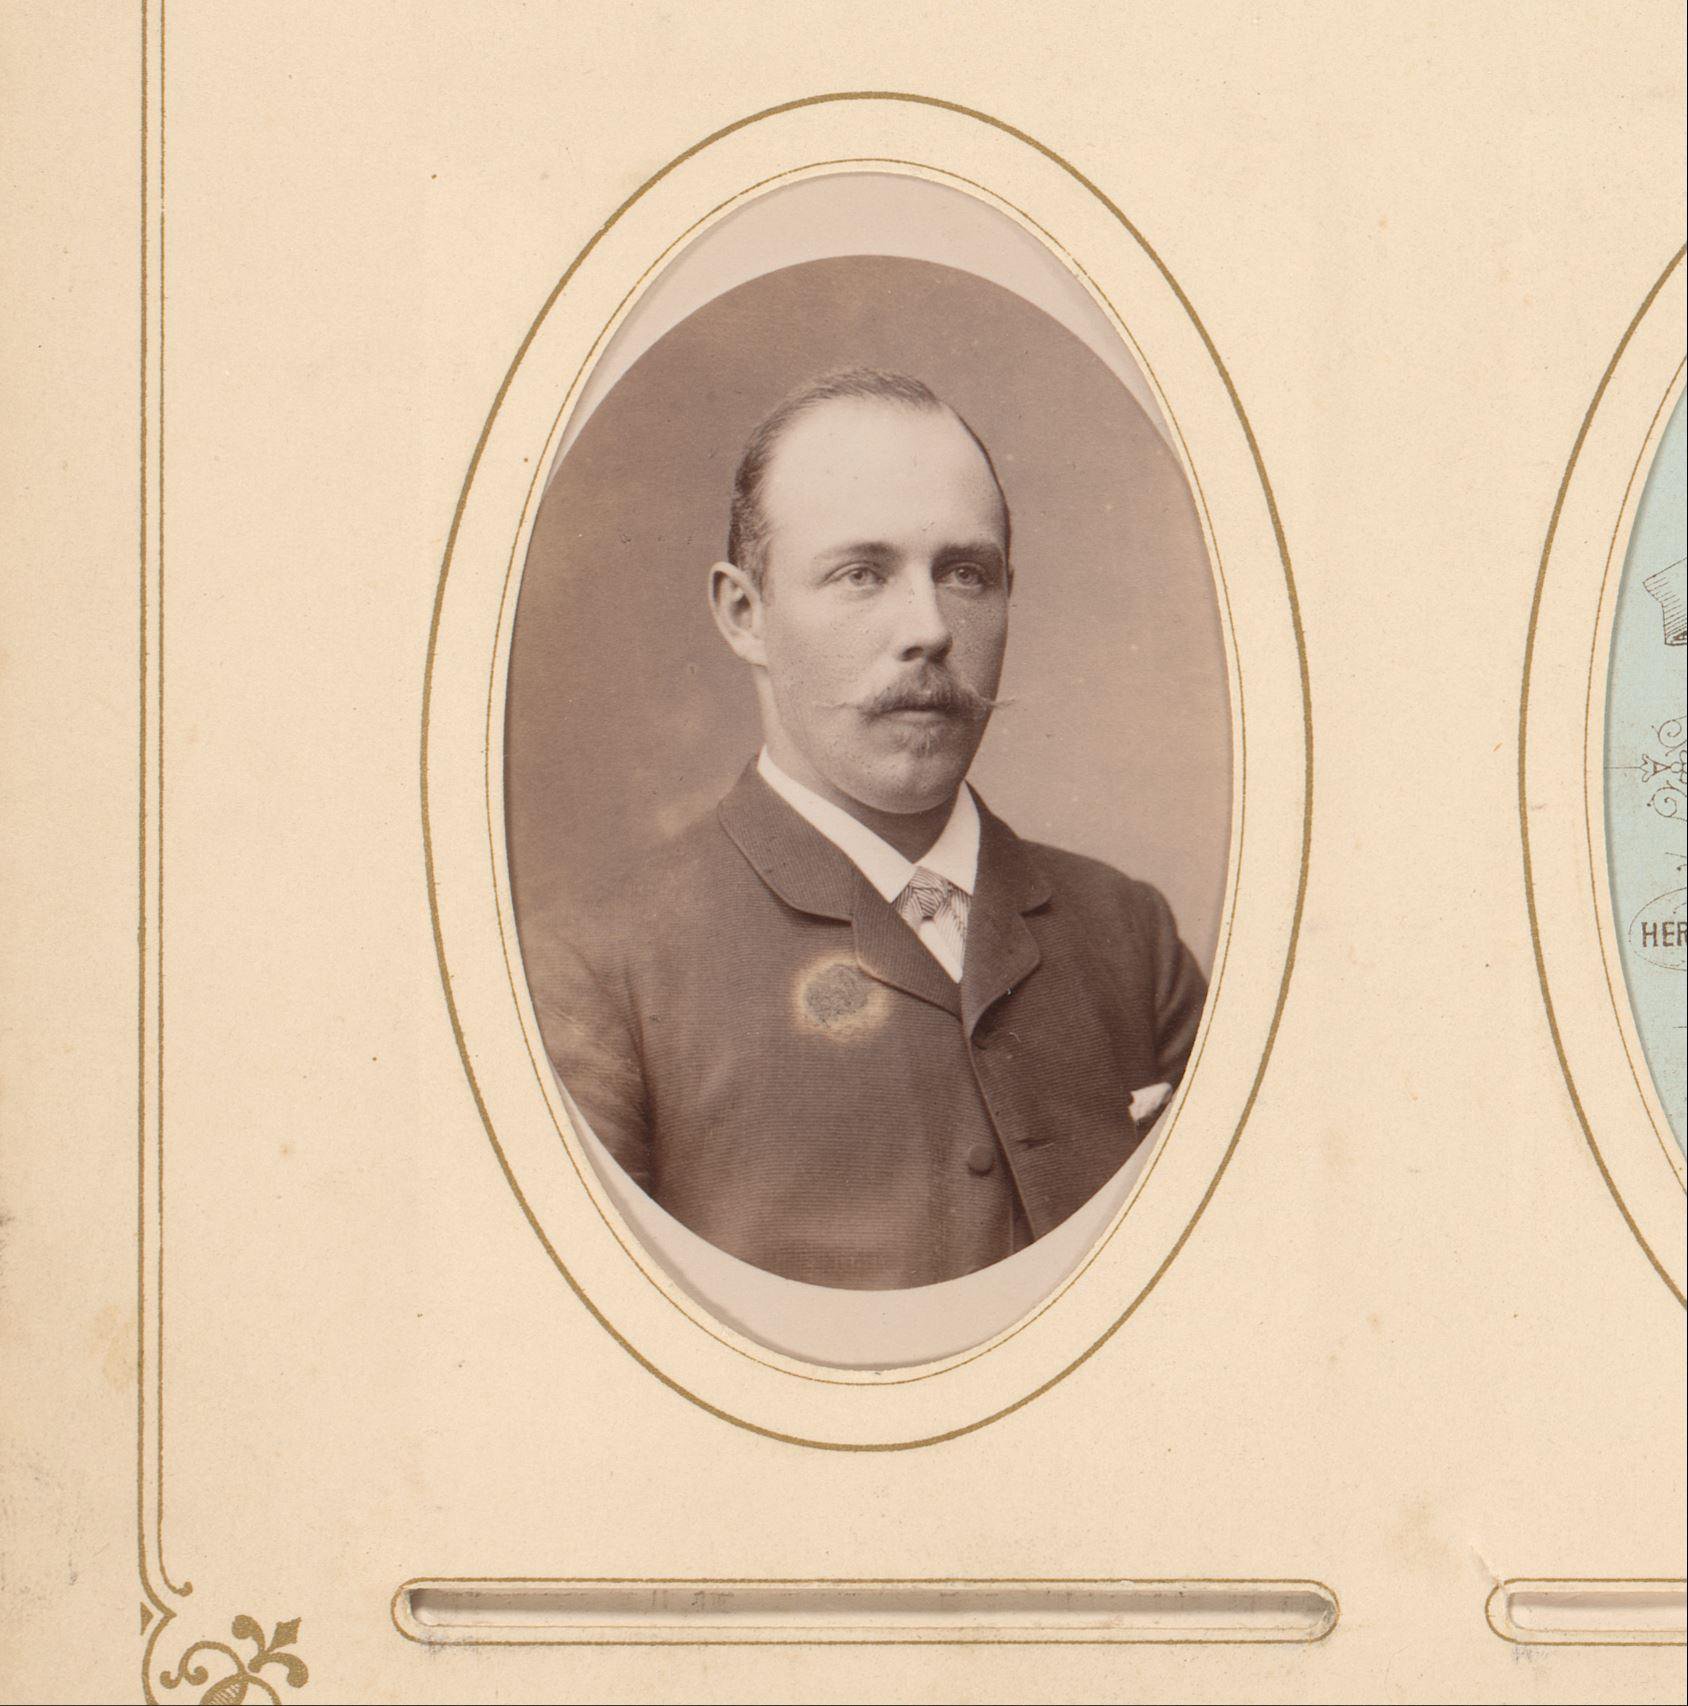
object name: carte de visite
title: Portret van een man met snor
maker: emilie bieber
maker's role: fotograaf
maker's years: 1810-1884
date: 1872-1884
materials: cardboard, photographic support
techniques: albumen print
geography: hamburg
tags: moustache, historical persons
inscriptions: inscription: ‘Die Platte bleibt für Nachbestellung aufbewahrt./ E. BIEBER/ K. HOF-PHOTOGRAPH/ HAMBURG/ NEUER JUNGFERNSTIEG 20. I ETAGE./ (...)/ Nach umstehenden Bilde fertige ich Copien vom kleinsten Format/ bis zur völligen Lebensgrösse an.’, annotation: ‘Willy Ba[...] †’